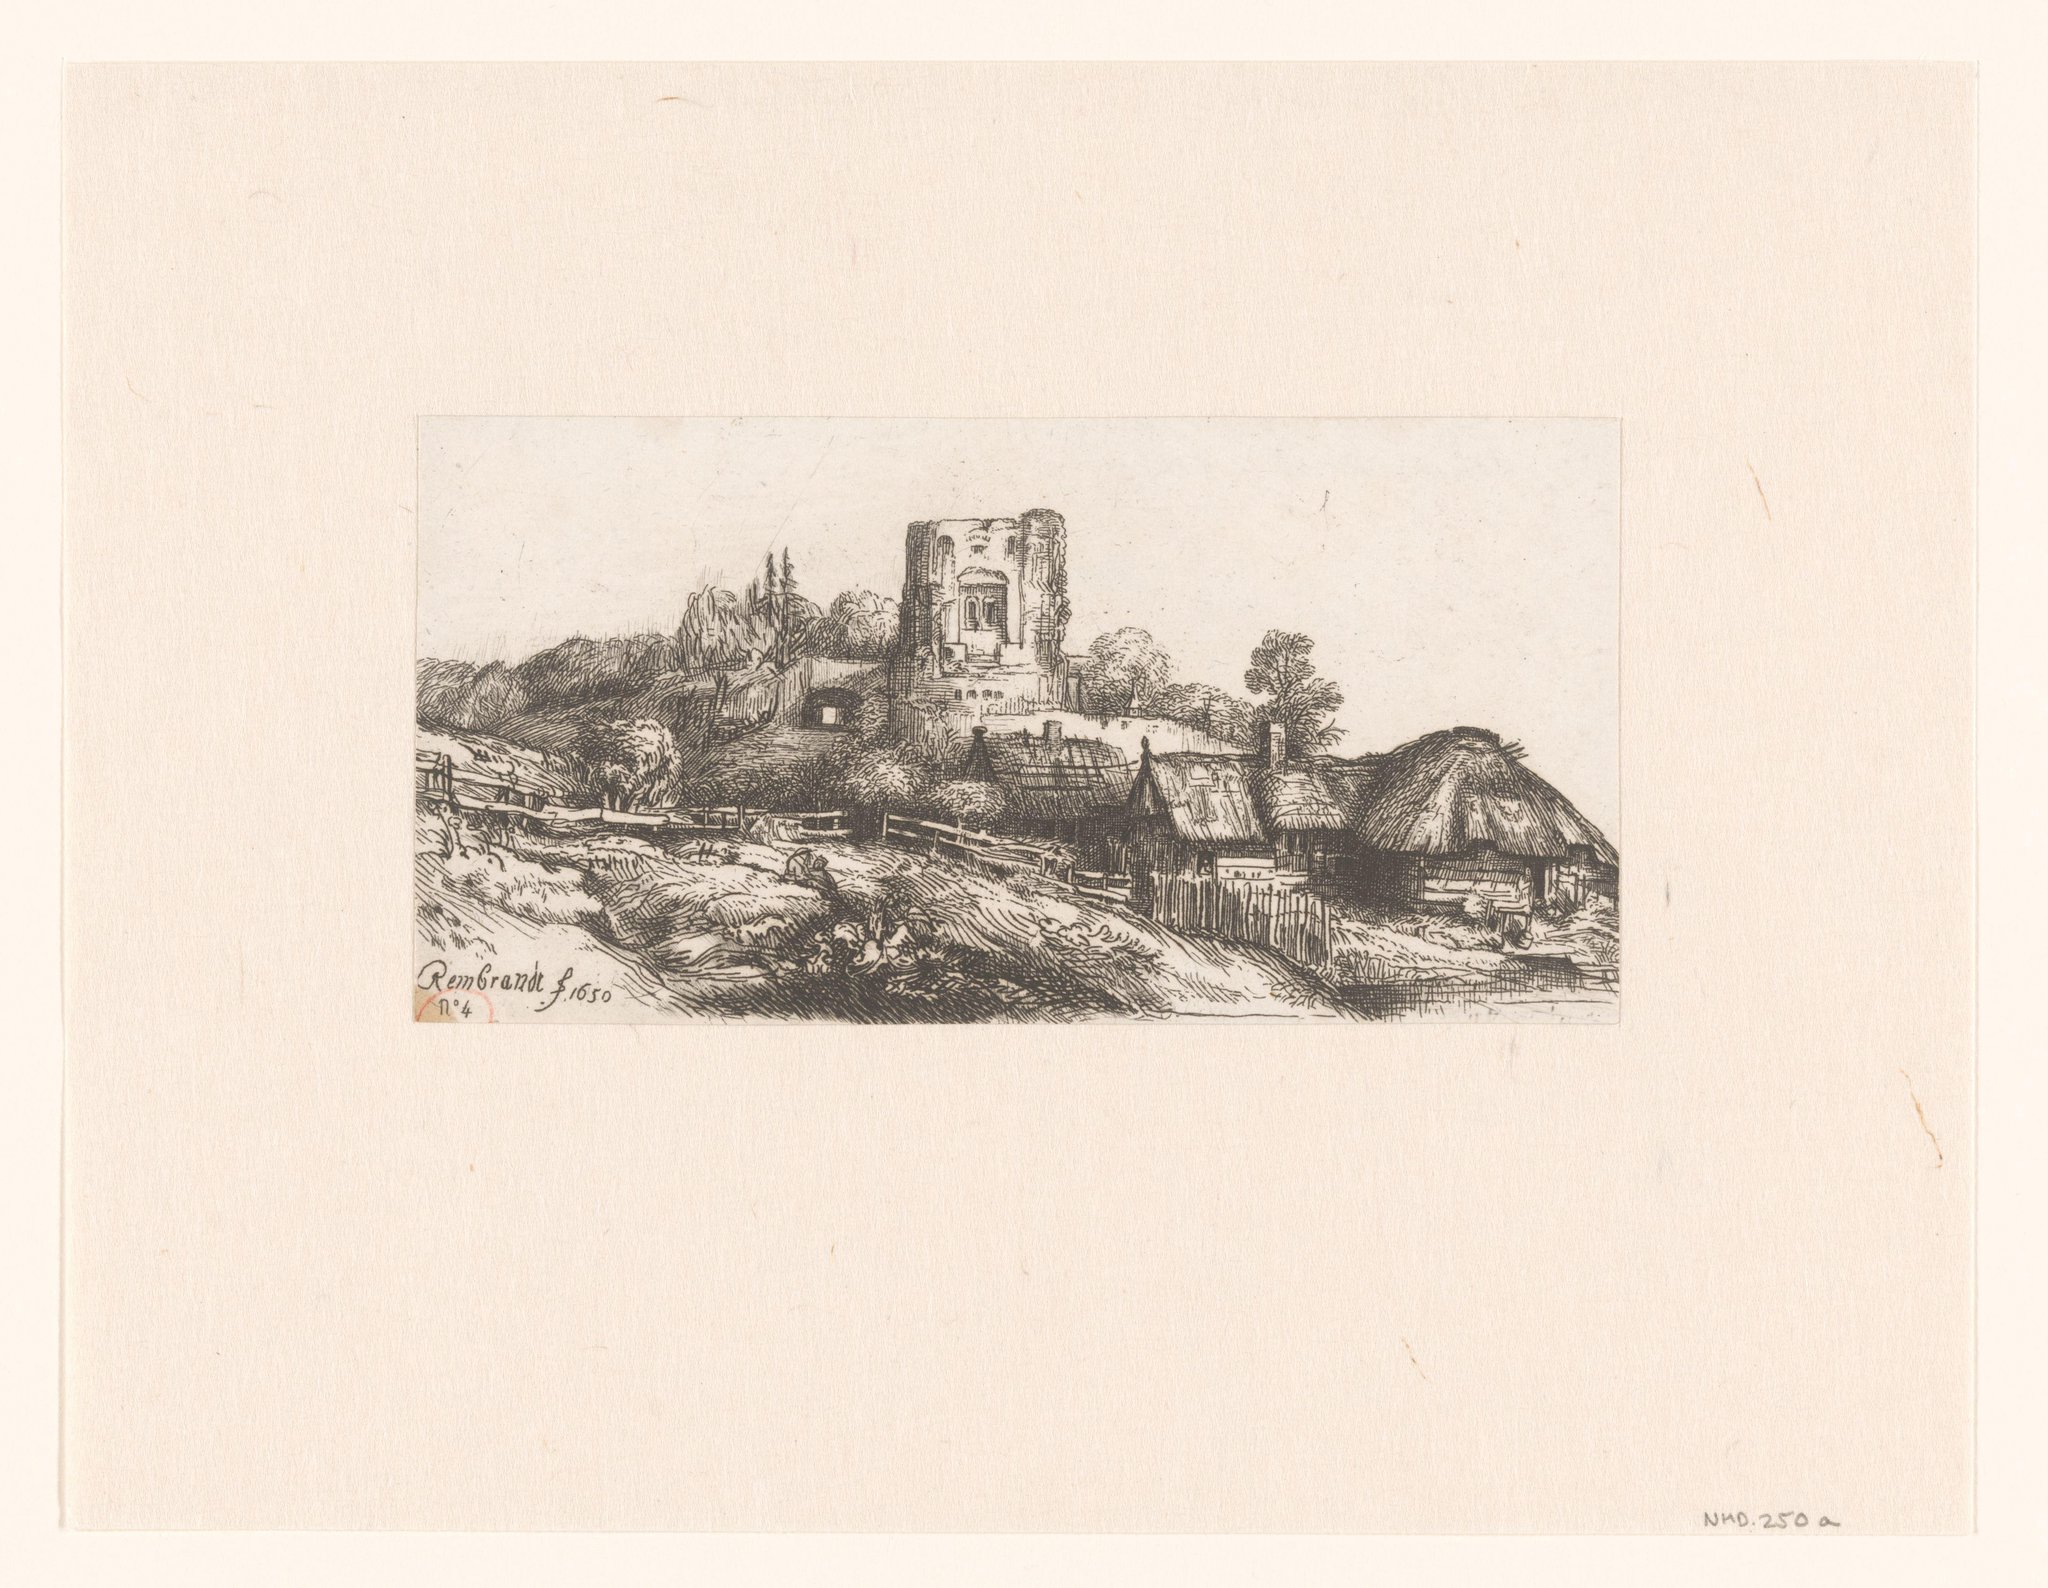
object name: print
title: Landscape with a square tower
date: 1719-1780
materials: paper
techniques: etching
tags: city-view, and landscape with man-made constructions, hut, cabin, lodge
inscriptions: collector's mark: Lugt 2228, collector's mark: Lugt 2760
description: Spiegelbeeldige kopie naar de gelijknamige prent van Rembrandt.